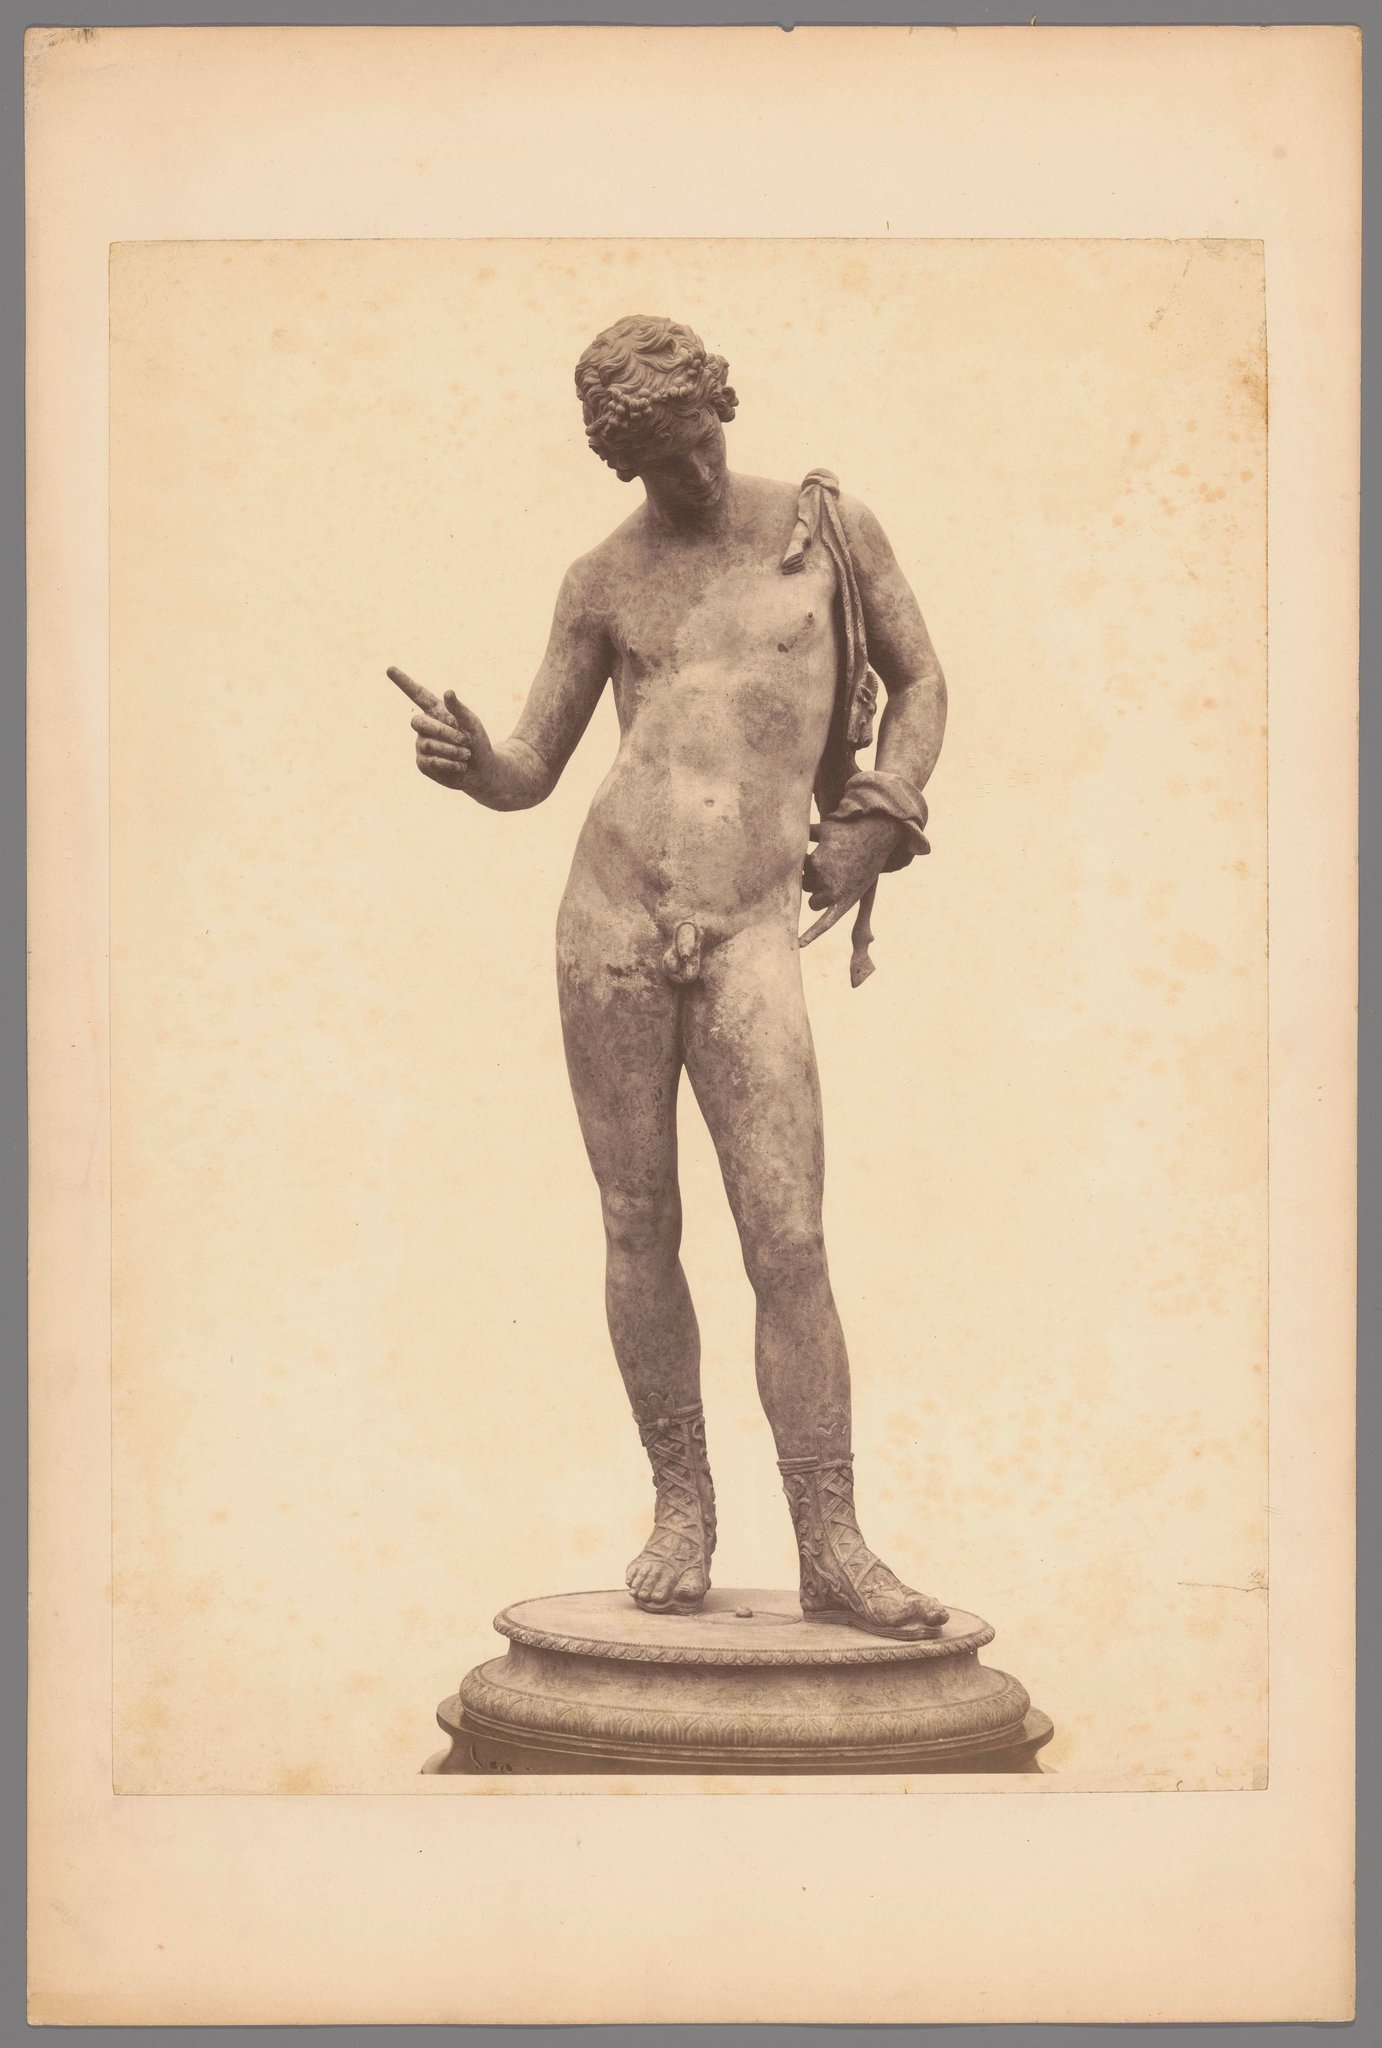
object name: photograph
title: Bronzen beeld van Narcissus, afkomstig van Pompeï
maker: Anonymous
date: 1875-1900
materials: cardboard, photographic support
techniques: albumen print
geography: naples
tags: (story of) narcissus, sculpture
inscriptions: collector's mark: Lugt 3937